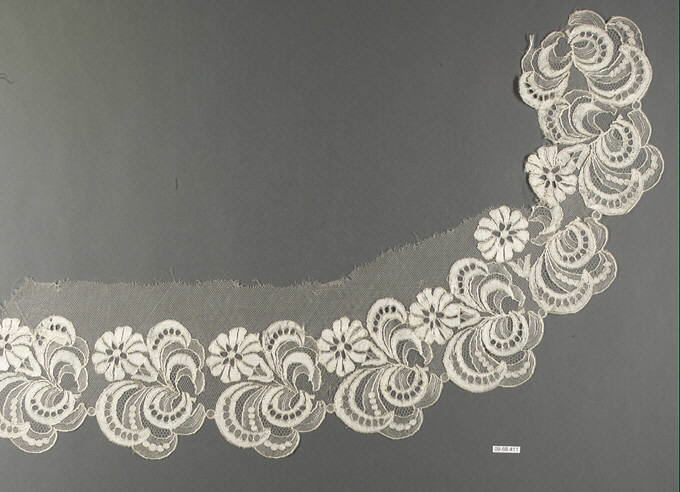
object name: bobbin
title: Silk bobbin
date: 1801-1900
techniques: lace